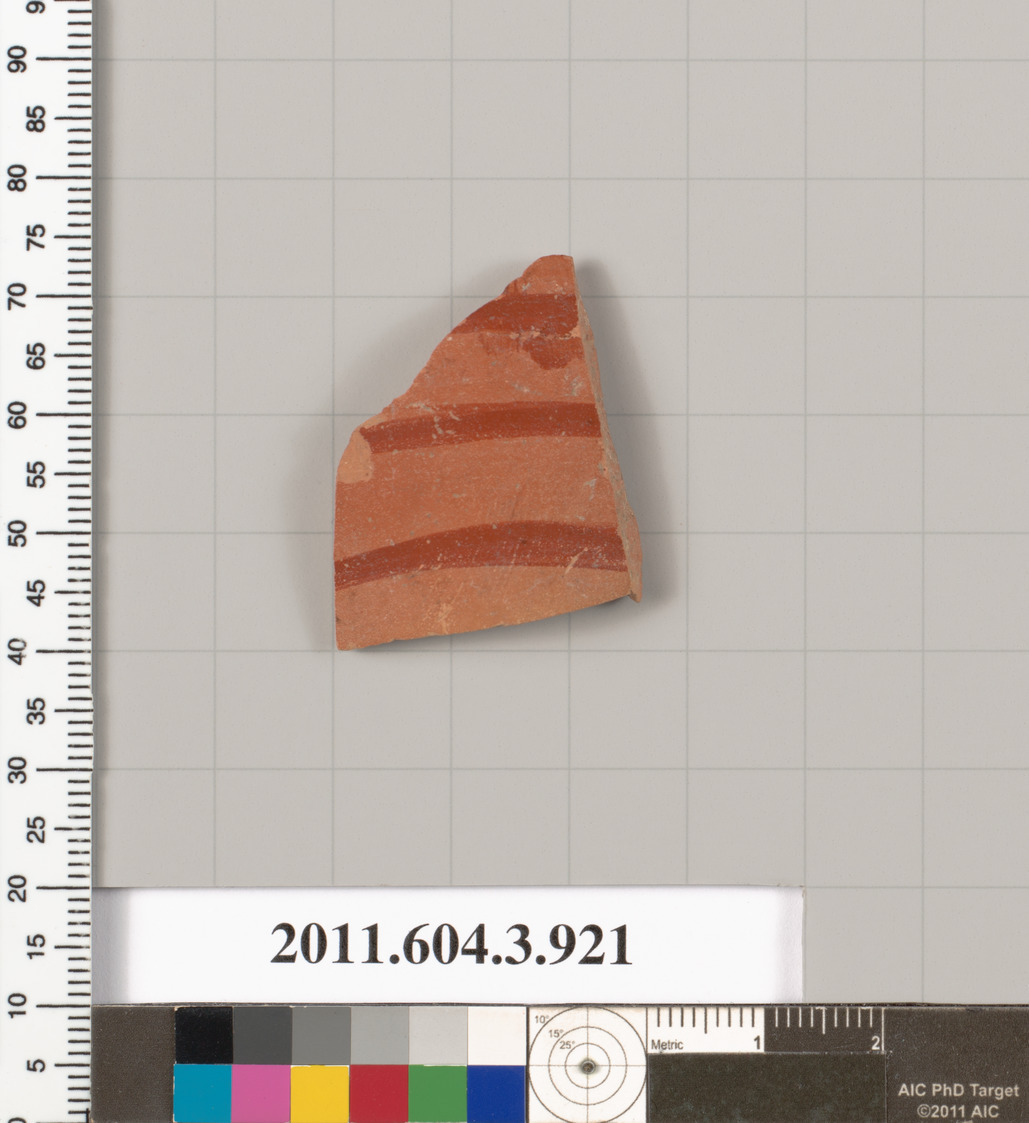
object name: lekythos fragment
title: Terracotta fragment of a lekythos (oil flask)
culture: greek, attic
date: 600-401 BCE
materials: terracotta